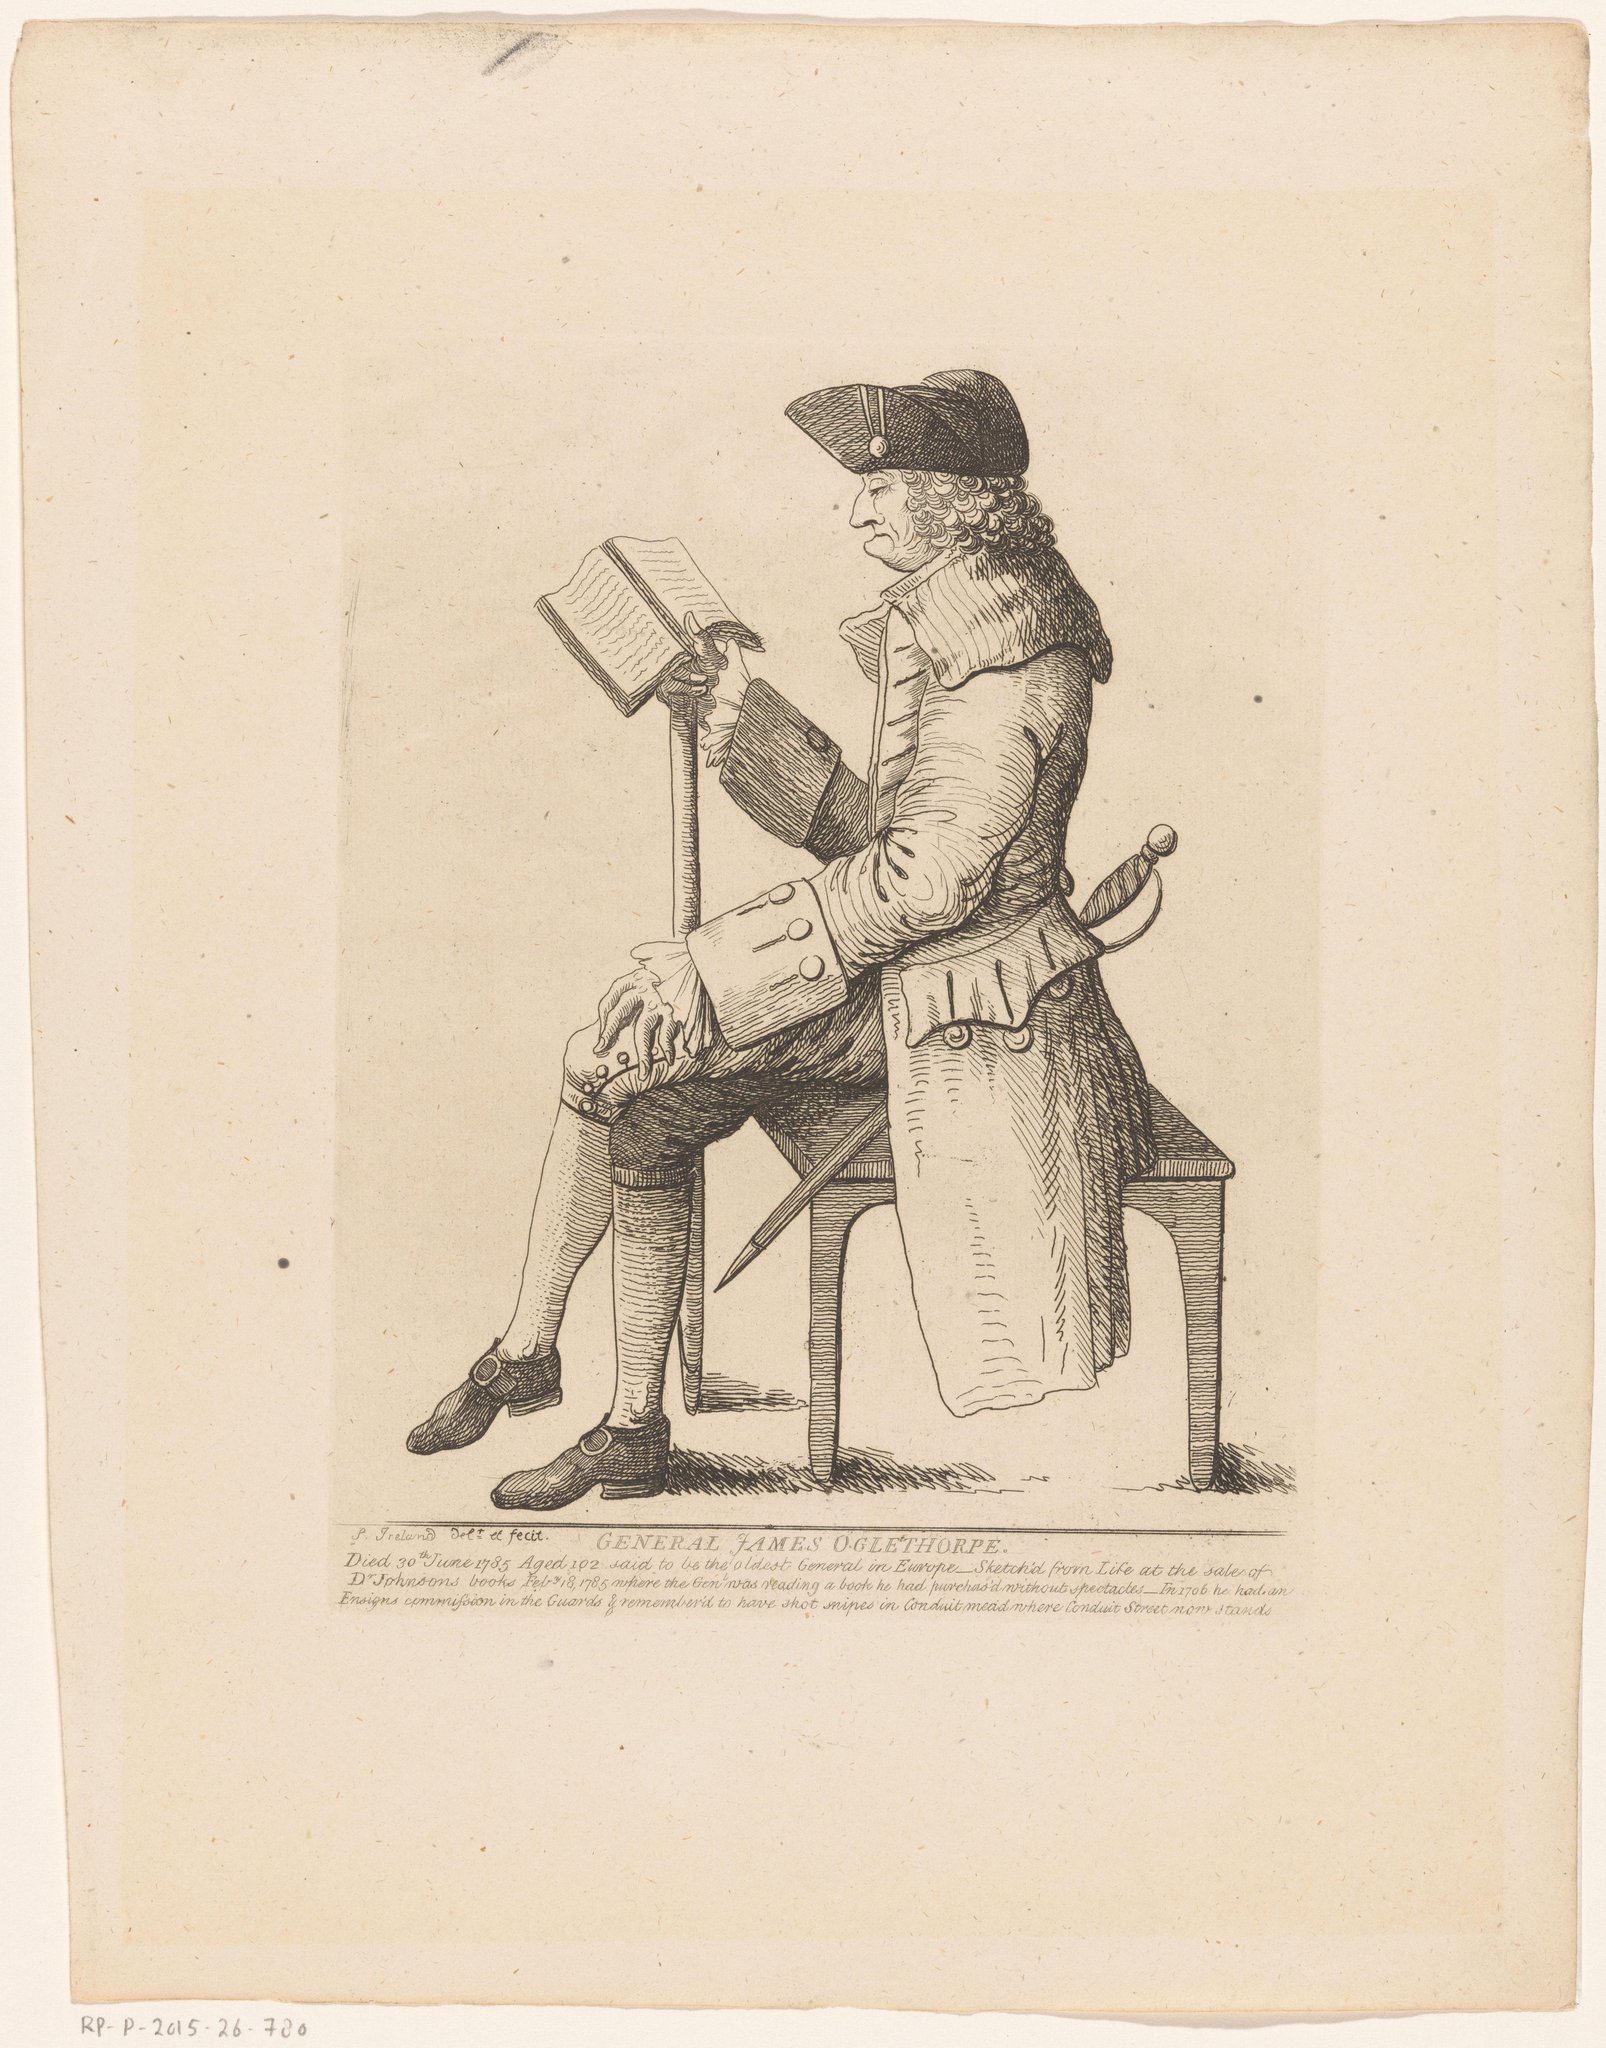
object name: print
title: Portret van Generaal James Oglethorpe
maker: samuel ireland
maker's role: print maker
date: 1785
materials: paper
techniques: etching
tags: london, head-gear: tricorn, commander-in-chief, general, marshal, book, art sale, auction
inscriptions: collector's mark: Lugt 4780, collector's mark: Lugt 2228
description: Portret van de generaal gezeten op een bankje met zijn benen over elkaar. Hij is gekleed in een lange jas en draagt een driehoekige steek op zijn hoofd, aan zijn linkerzij is een zwaard bevestigd. Met rechts houdt hij een boek vast, zijn hand leunend op een wandelstok.